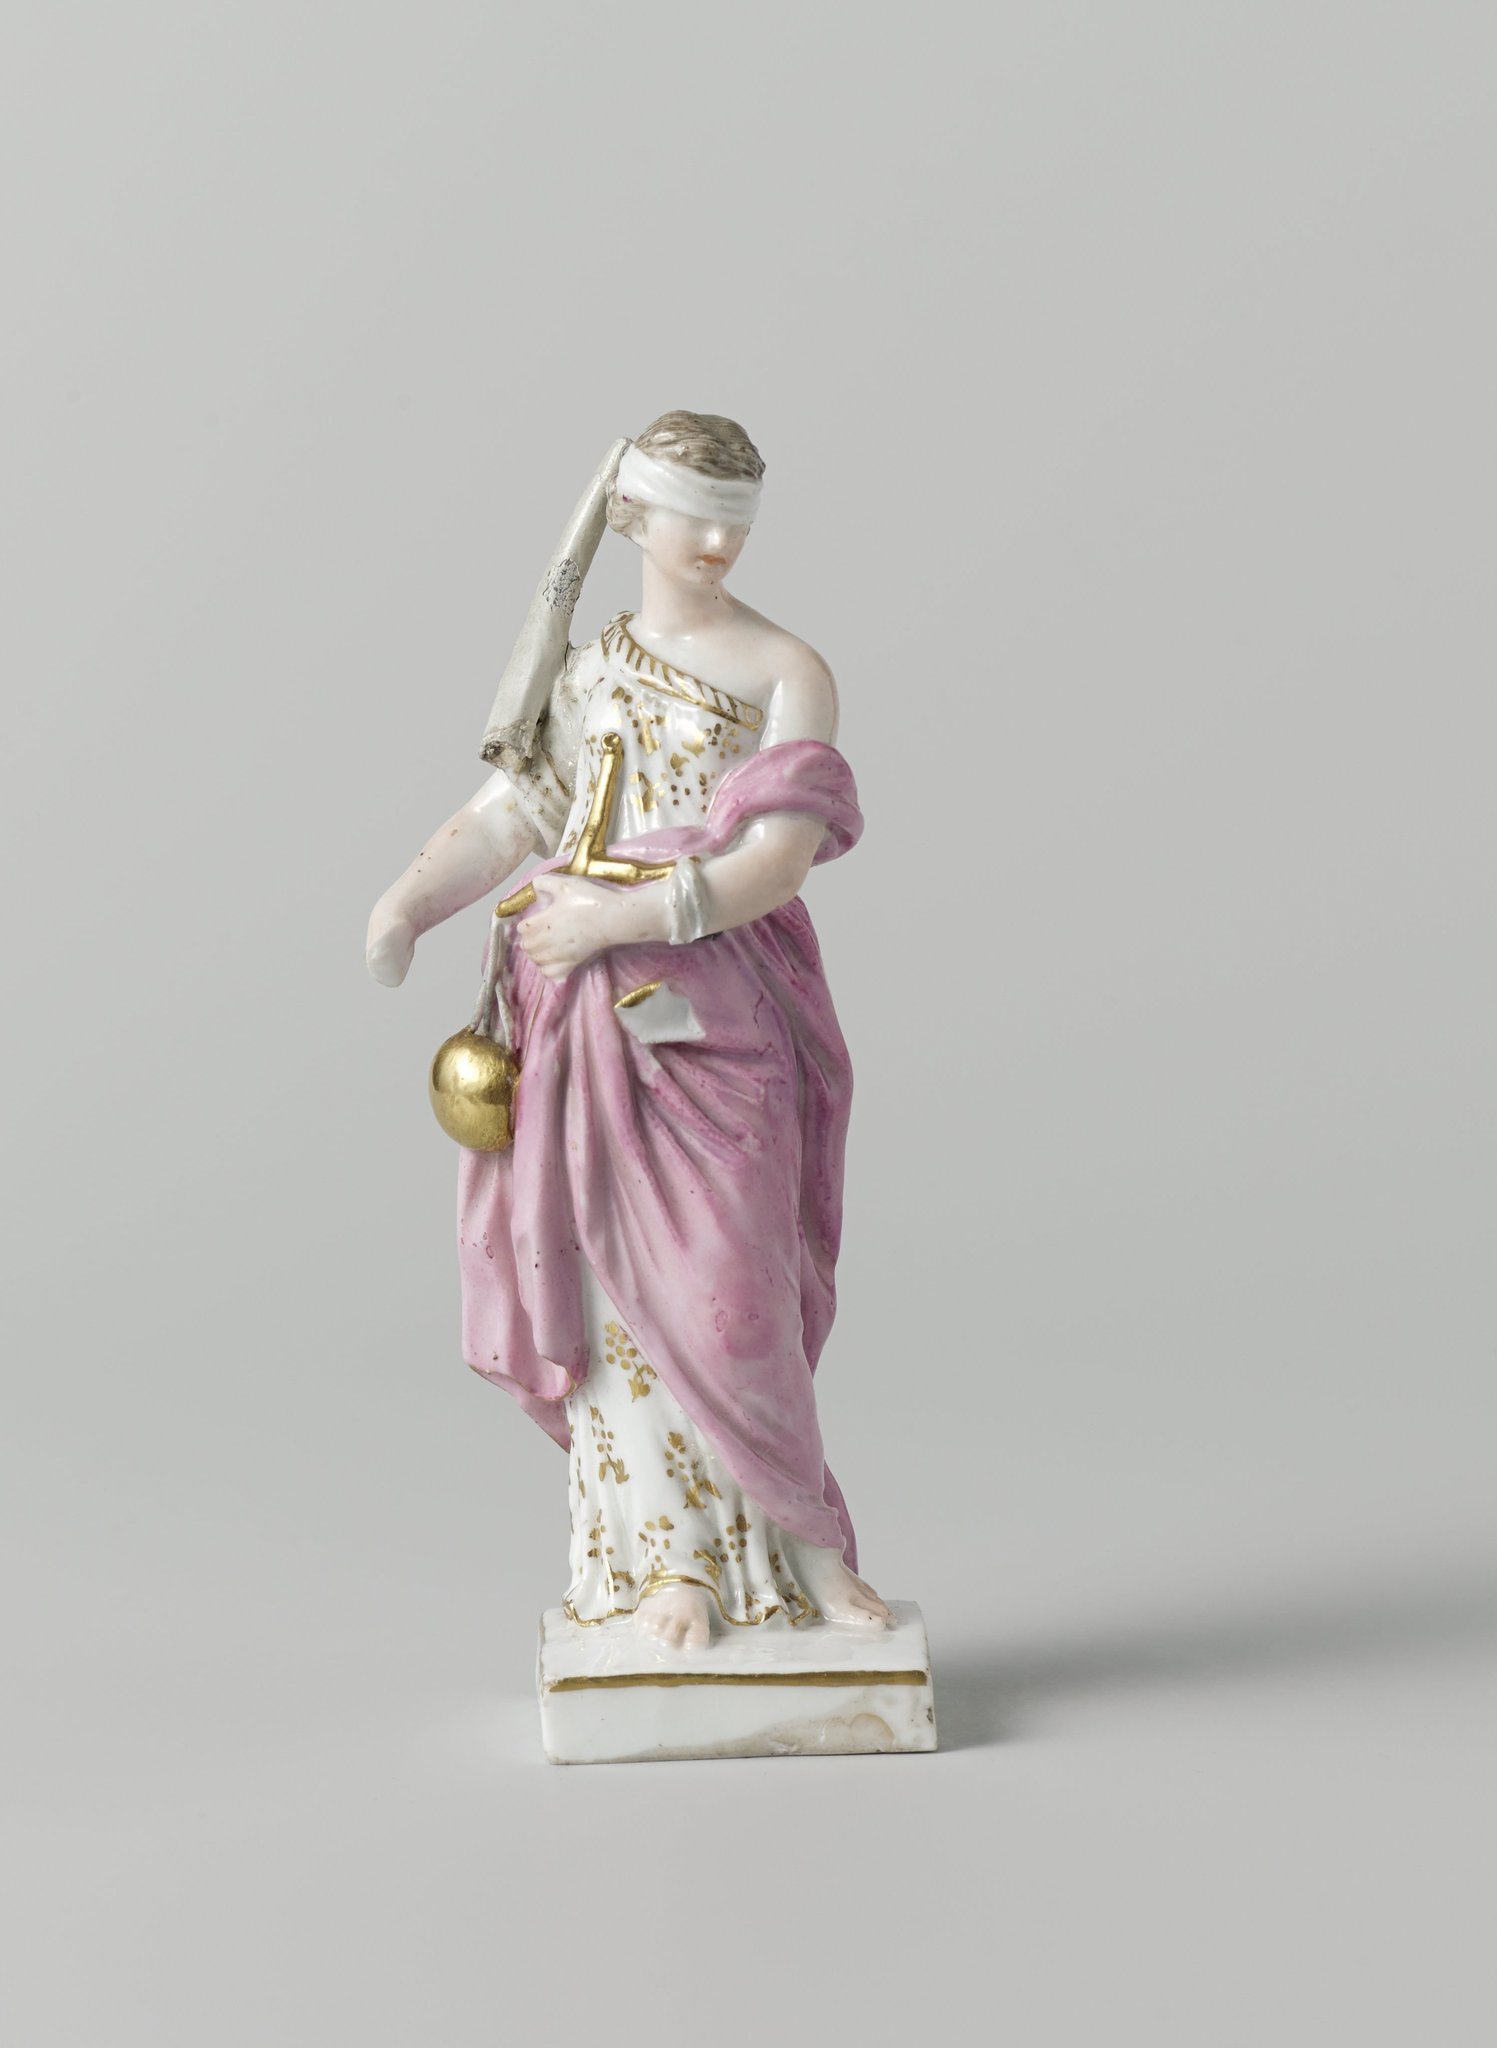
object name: figure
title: Justitia (Gerechtigheid)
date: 1779-1800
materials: porcelain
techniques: painted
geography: meissen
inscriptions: factory mark, model number: ‘560’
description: Figuur van beschilderd porselein. Op een vierkant goud gerand voetstuk staat een vrouw (Justitia) met een zwaard in haar rechterhand en een weegschaal over haar linkerarm. Zij is geblinddoekt. De figuur is gemerkt.